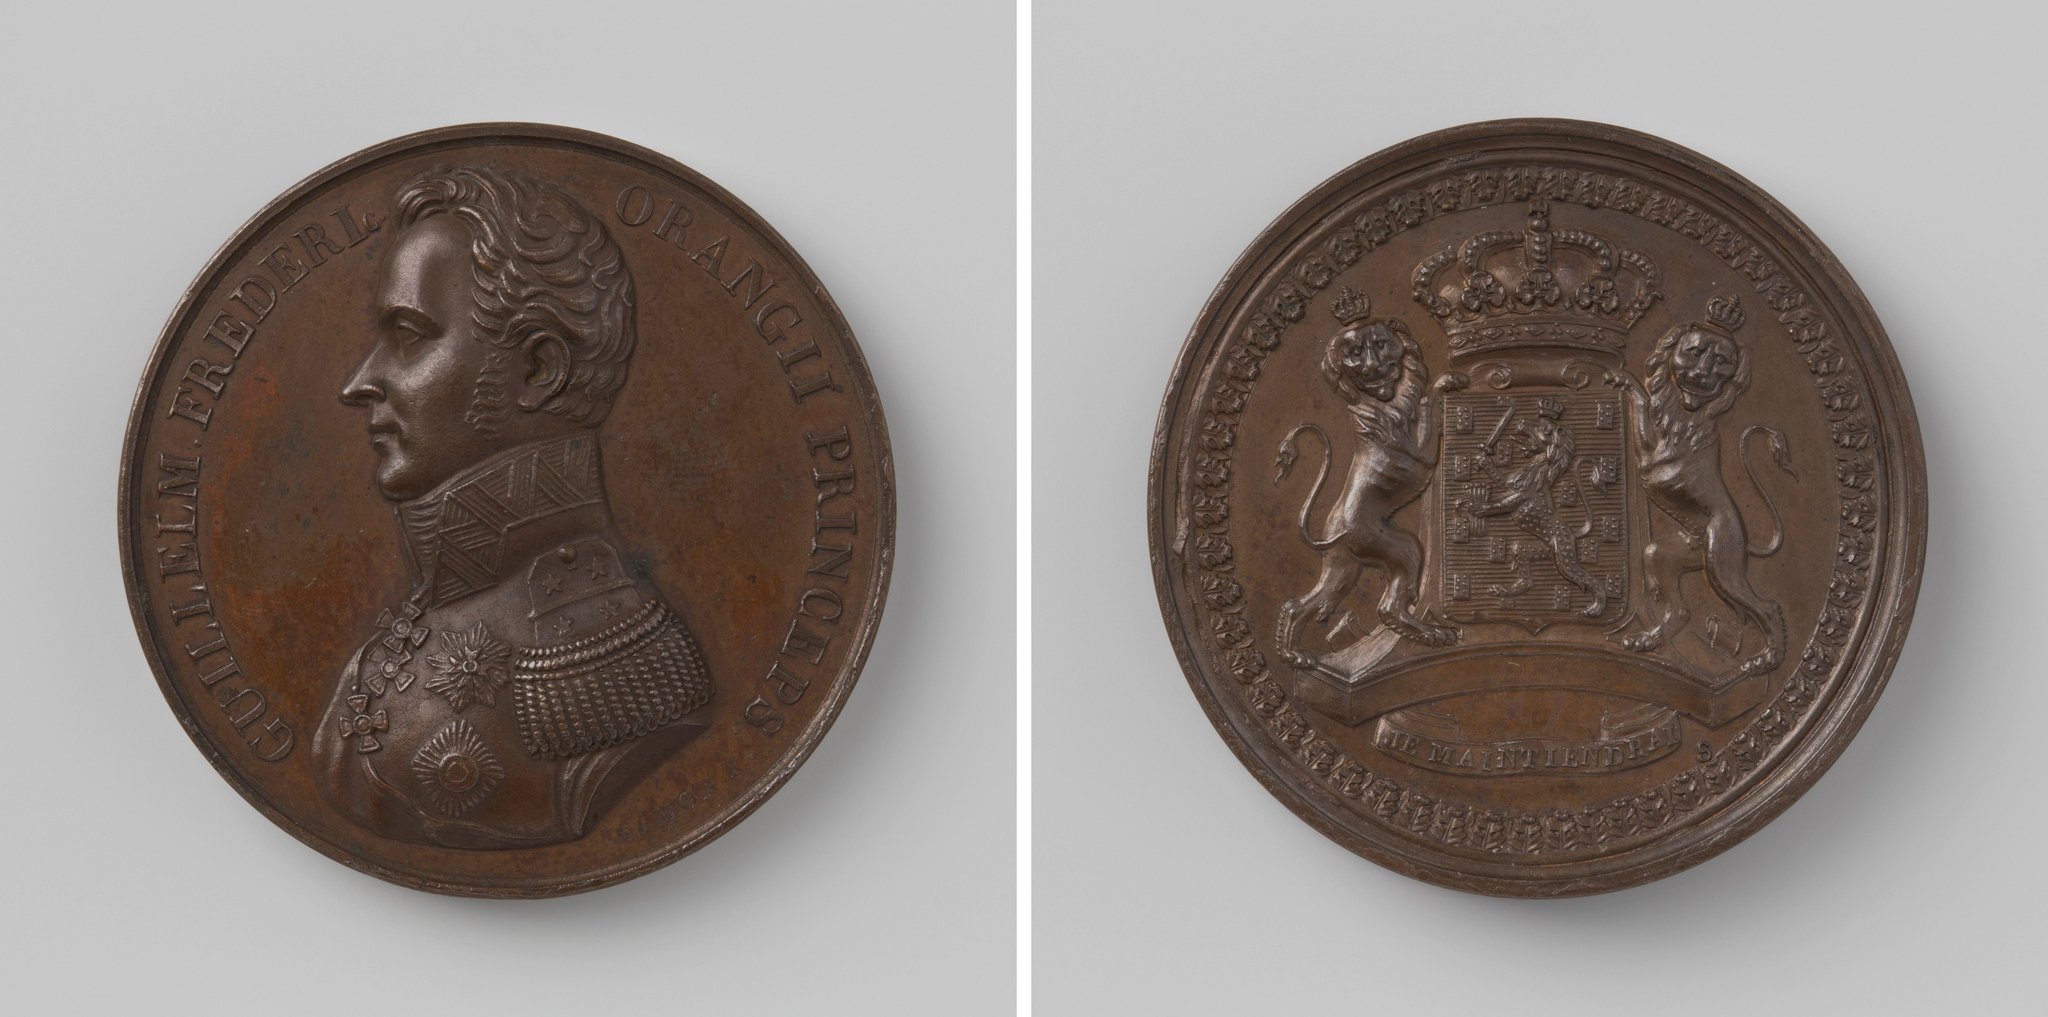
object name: history medal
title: Frederik, prins der Nederlanden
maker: jean henri simon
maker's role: medailleur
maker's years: 1752-1834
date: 1845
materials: bronze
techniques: striking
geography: brussels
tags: berlin, frederik (prins der nederlanden)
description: Bronzen penning. Voorzijde: borststuk man binnen omschrift. Keerzijde: gekroond wapenschild, geflankeerddoor twee gekroonde leeuwen boven wimpel met opschrift binnen sierrand